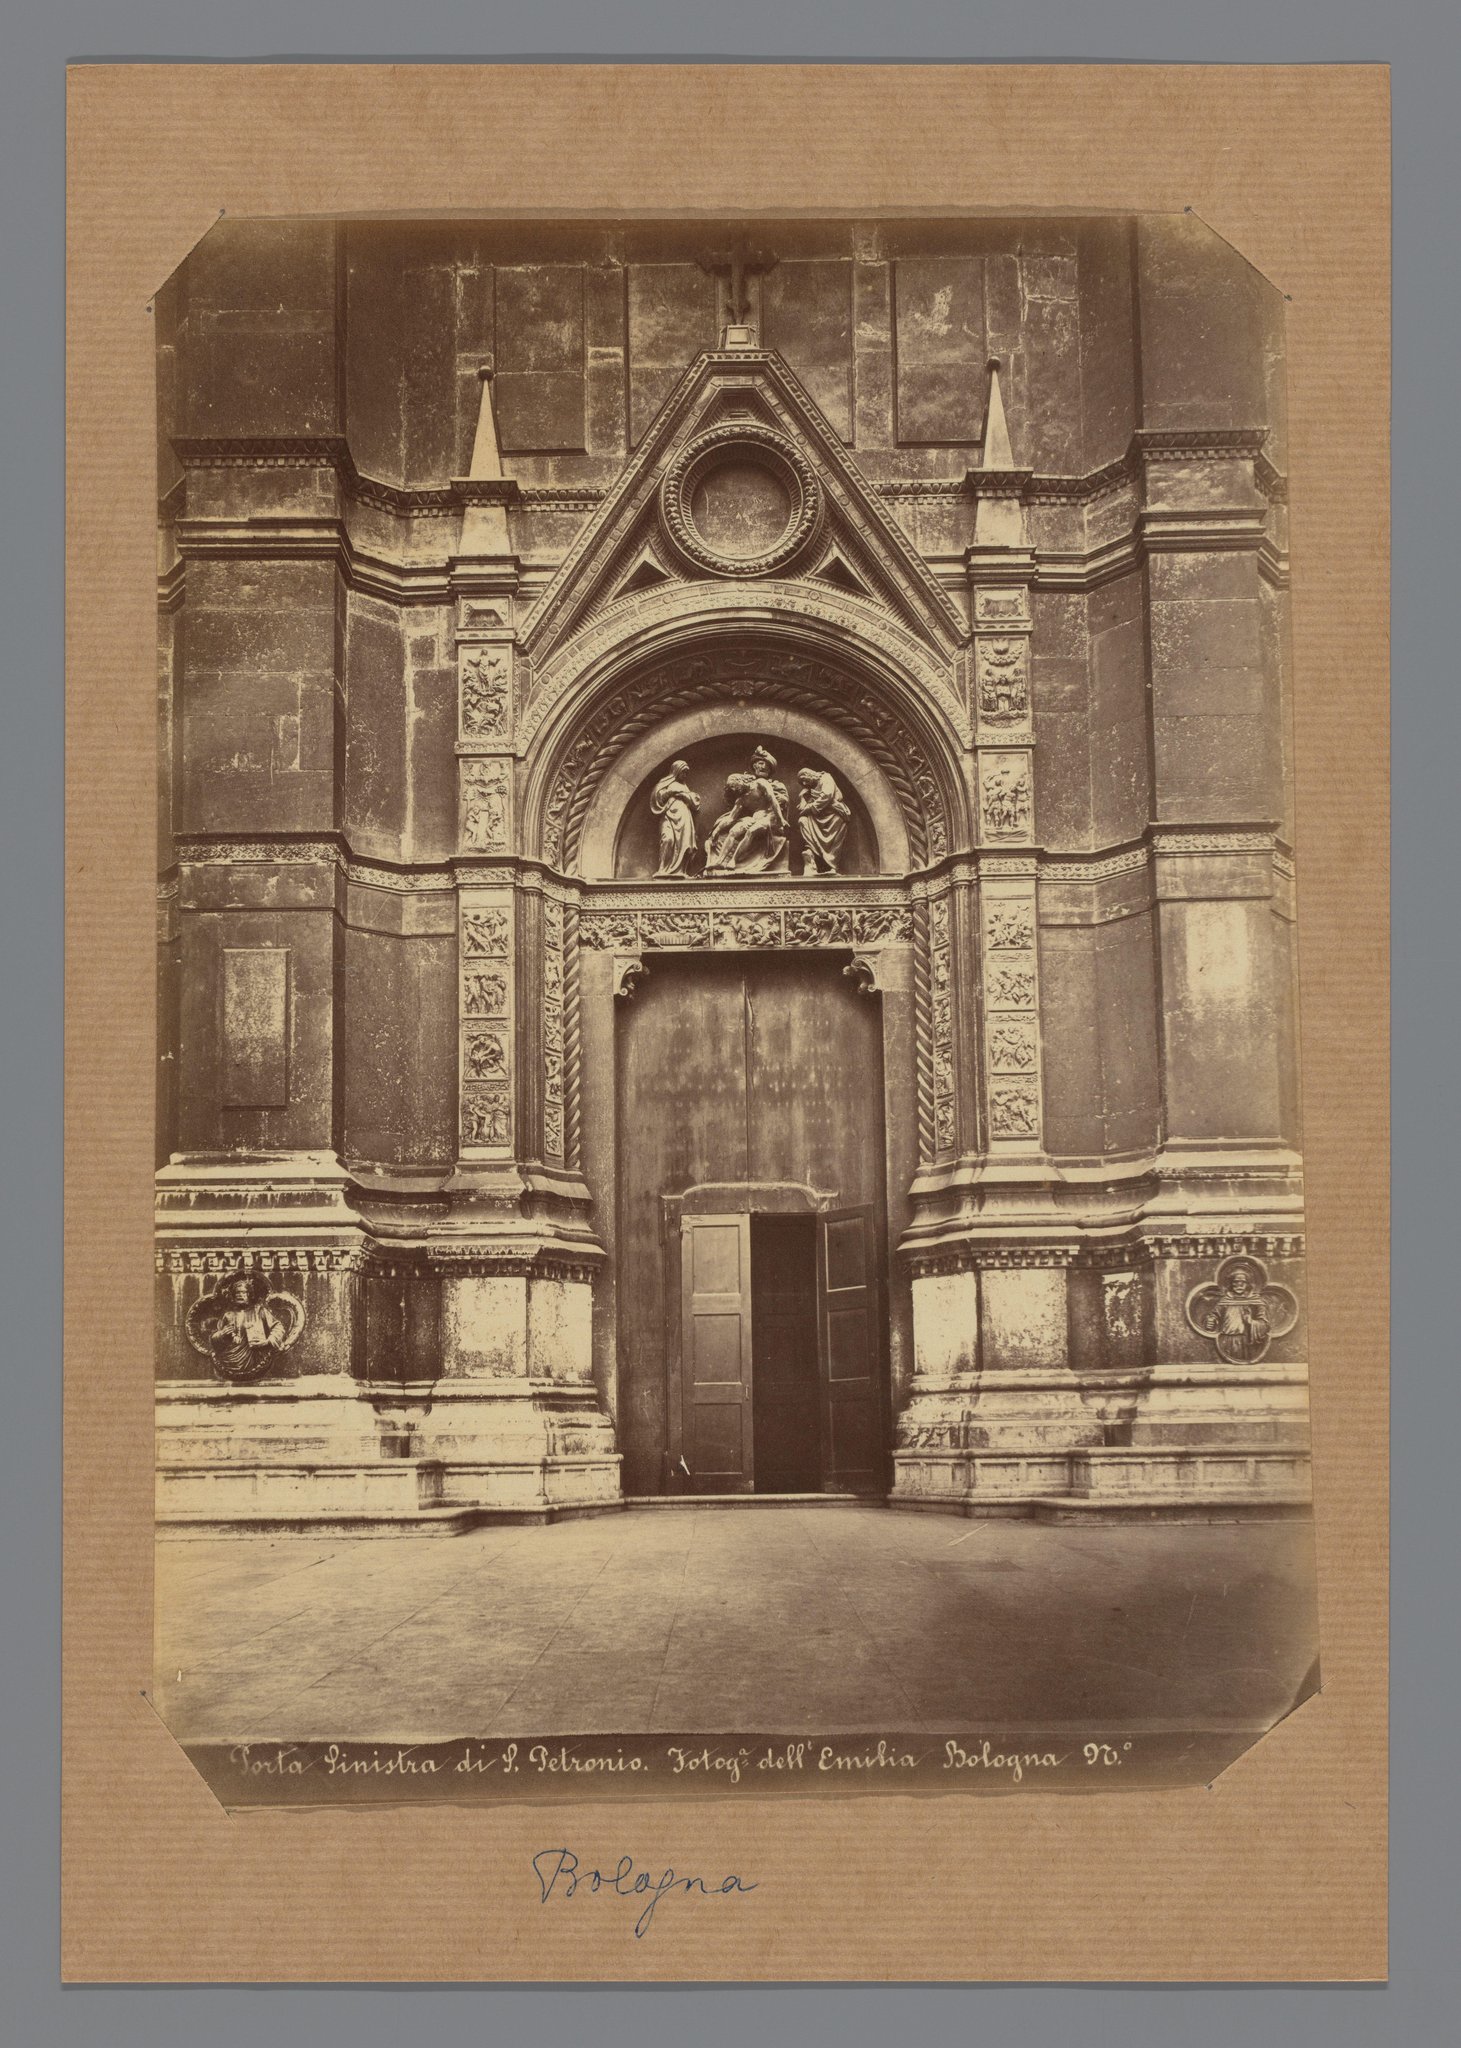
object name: photograph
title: Italië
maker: Anonymous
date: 1880-1910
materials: photographic support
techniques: albumen print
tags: italy